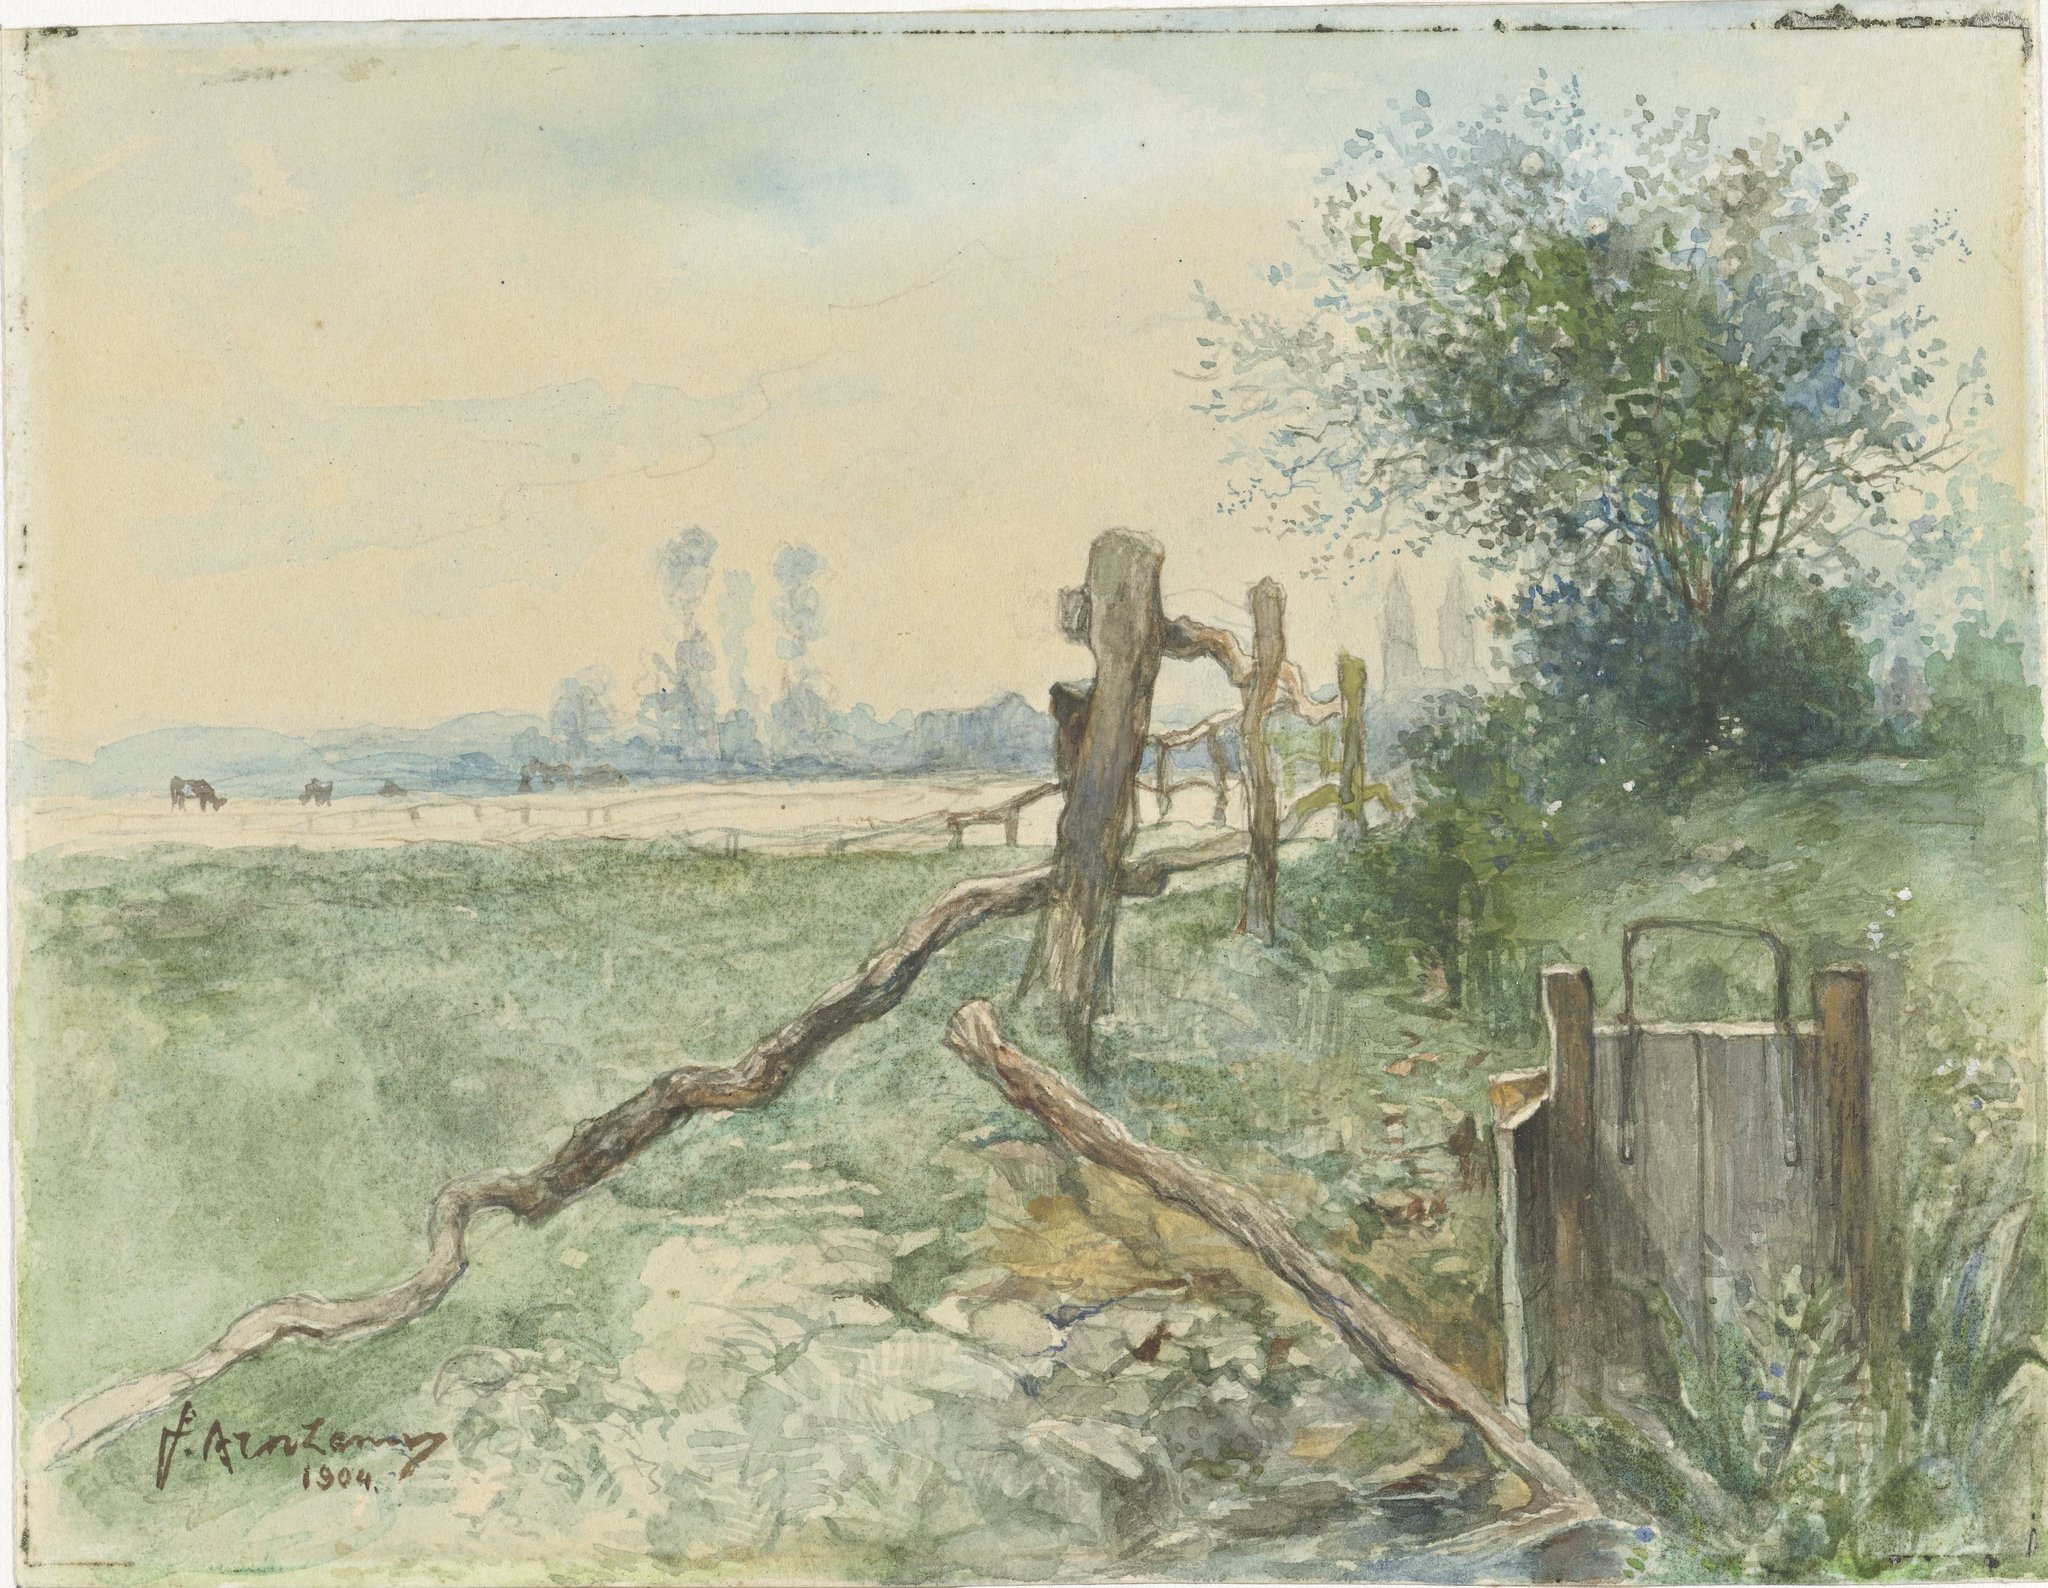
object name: watercolor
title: Weidelandschap met sloot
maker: floris arntzenius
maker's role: draughtsman, print maker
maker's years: 1864-1925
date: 1904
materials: paper, watercolor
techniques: brush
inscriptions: date: ‘1904’